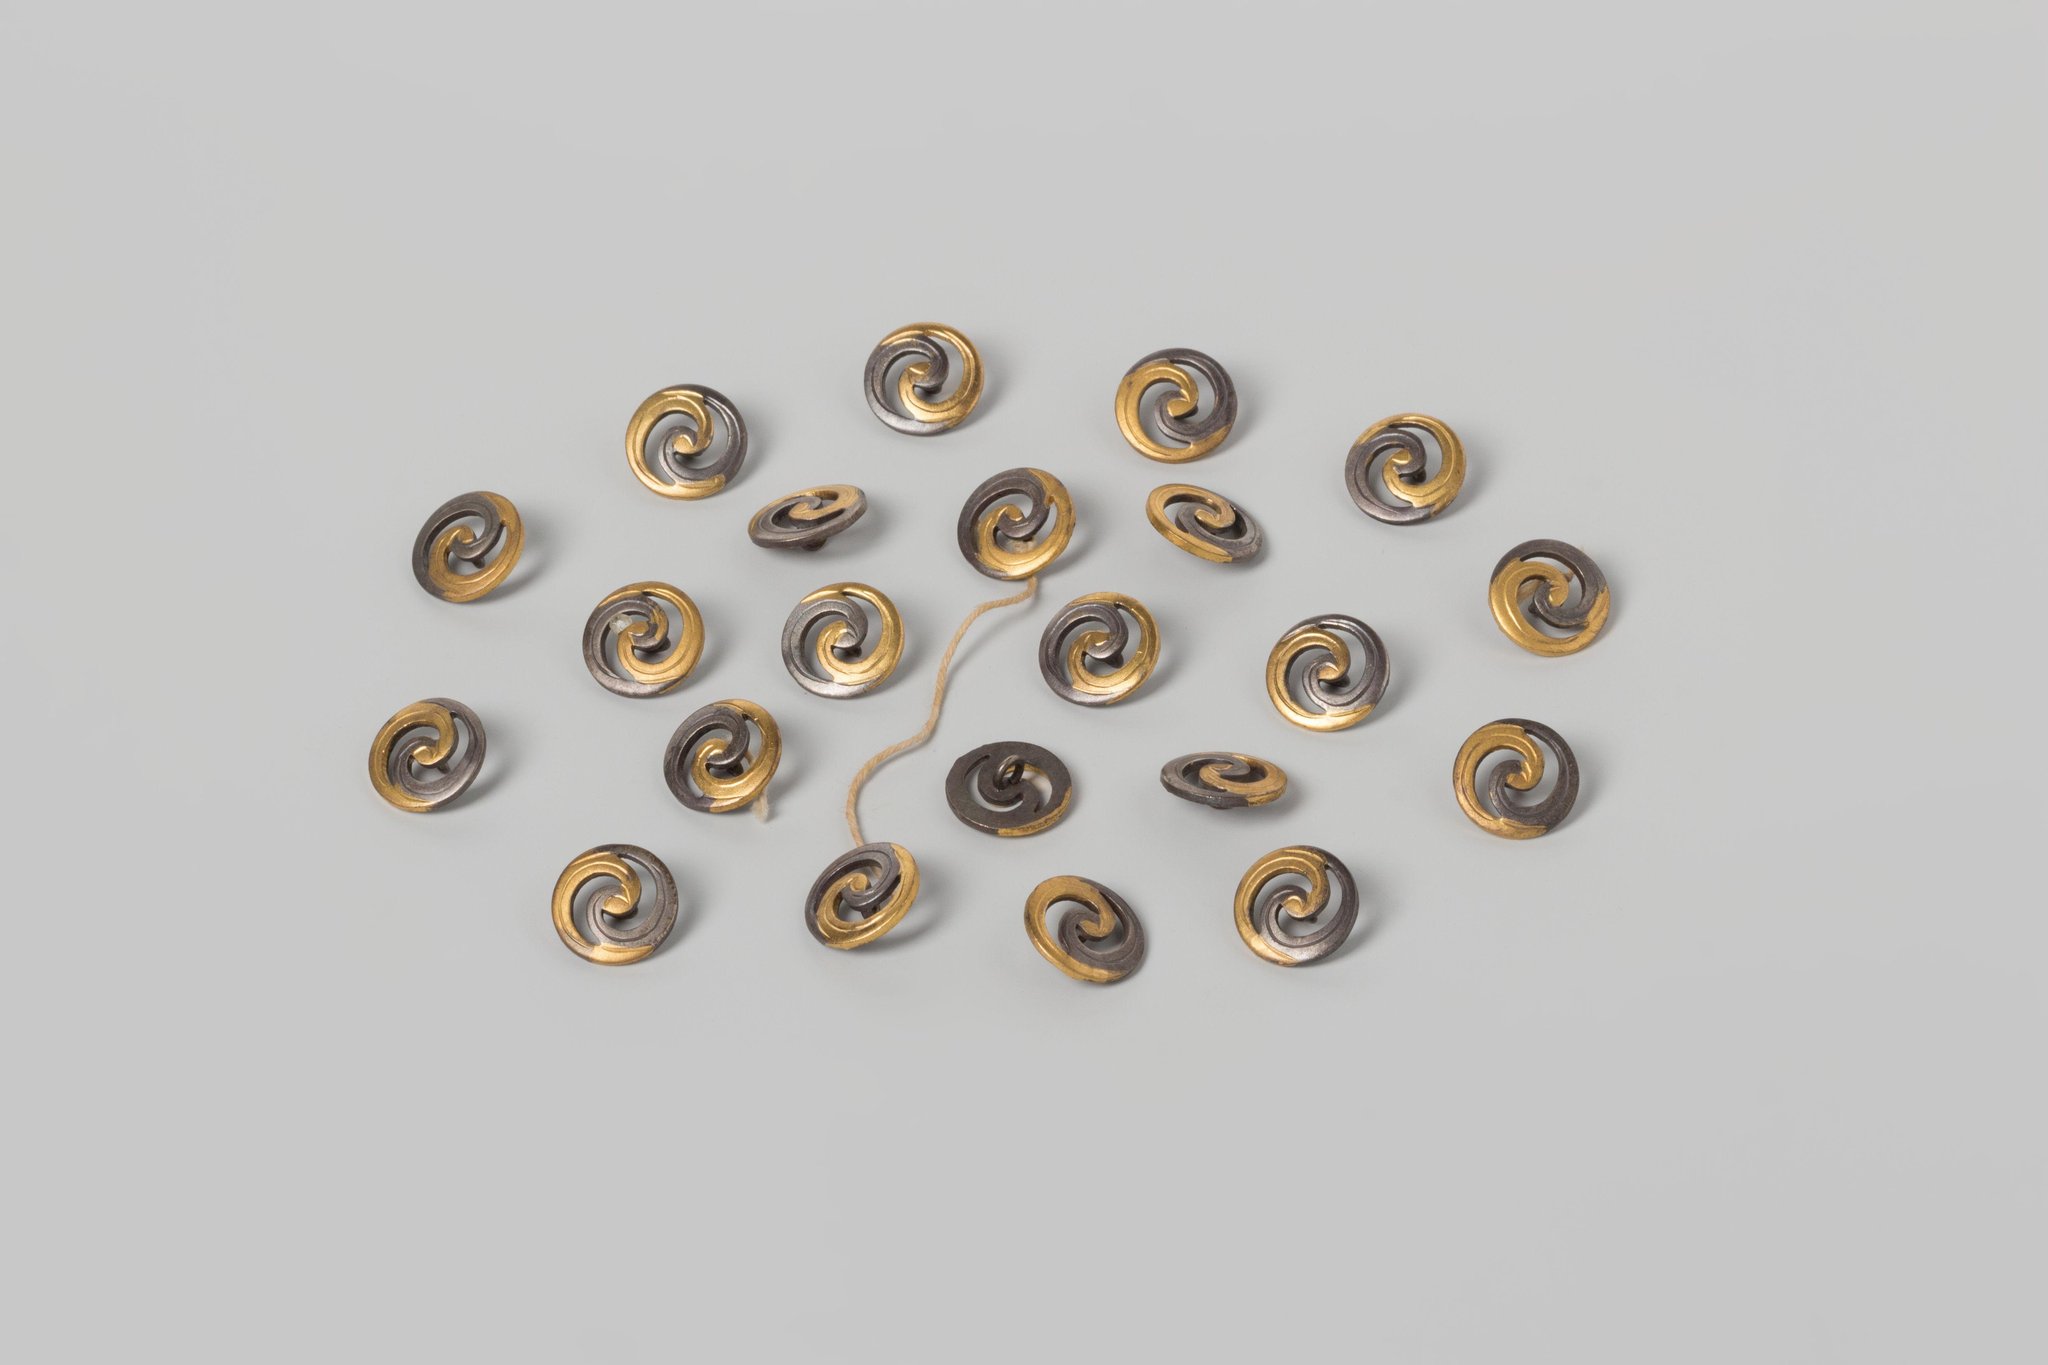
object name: clothing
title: Knoop, plat en rond, van gedeeltelijk met goudverf beschilderd metaal met krulmotief, gelijkend yin en yang, opengewerkt en gegraveerd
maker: Anonymous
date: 1880-1940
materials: paint, metal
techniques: embroidery, engraving, painting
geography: europe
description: Knoop, plat en rond, van gedeeltelijk met goudverf beschilderd metaal met krulmotief, gelijkend yin en yang, opengewerkt en gegraveerd.